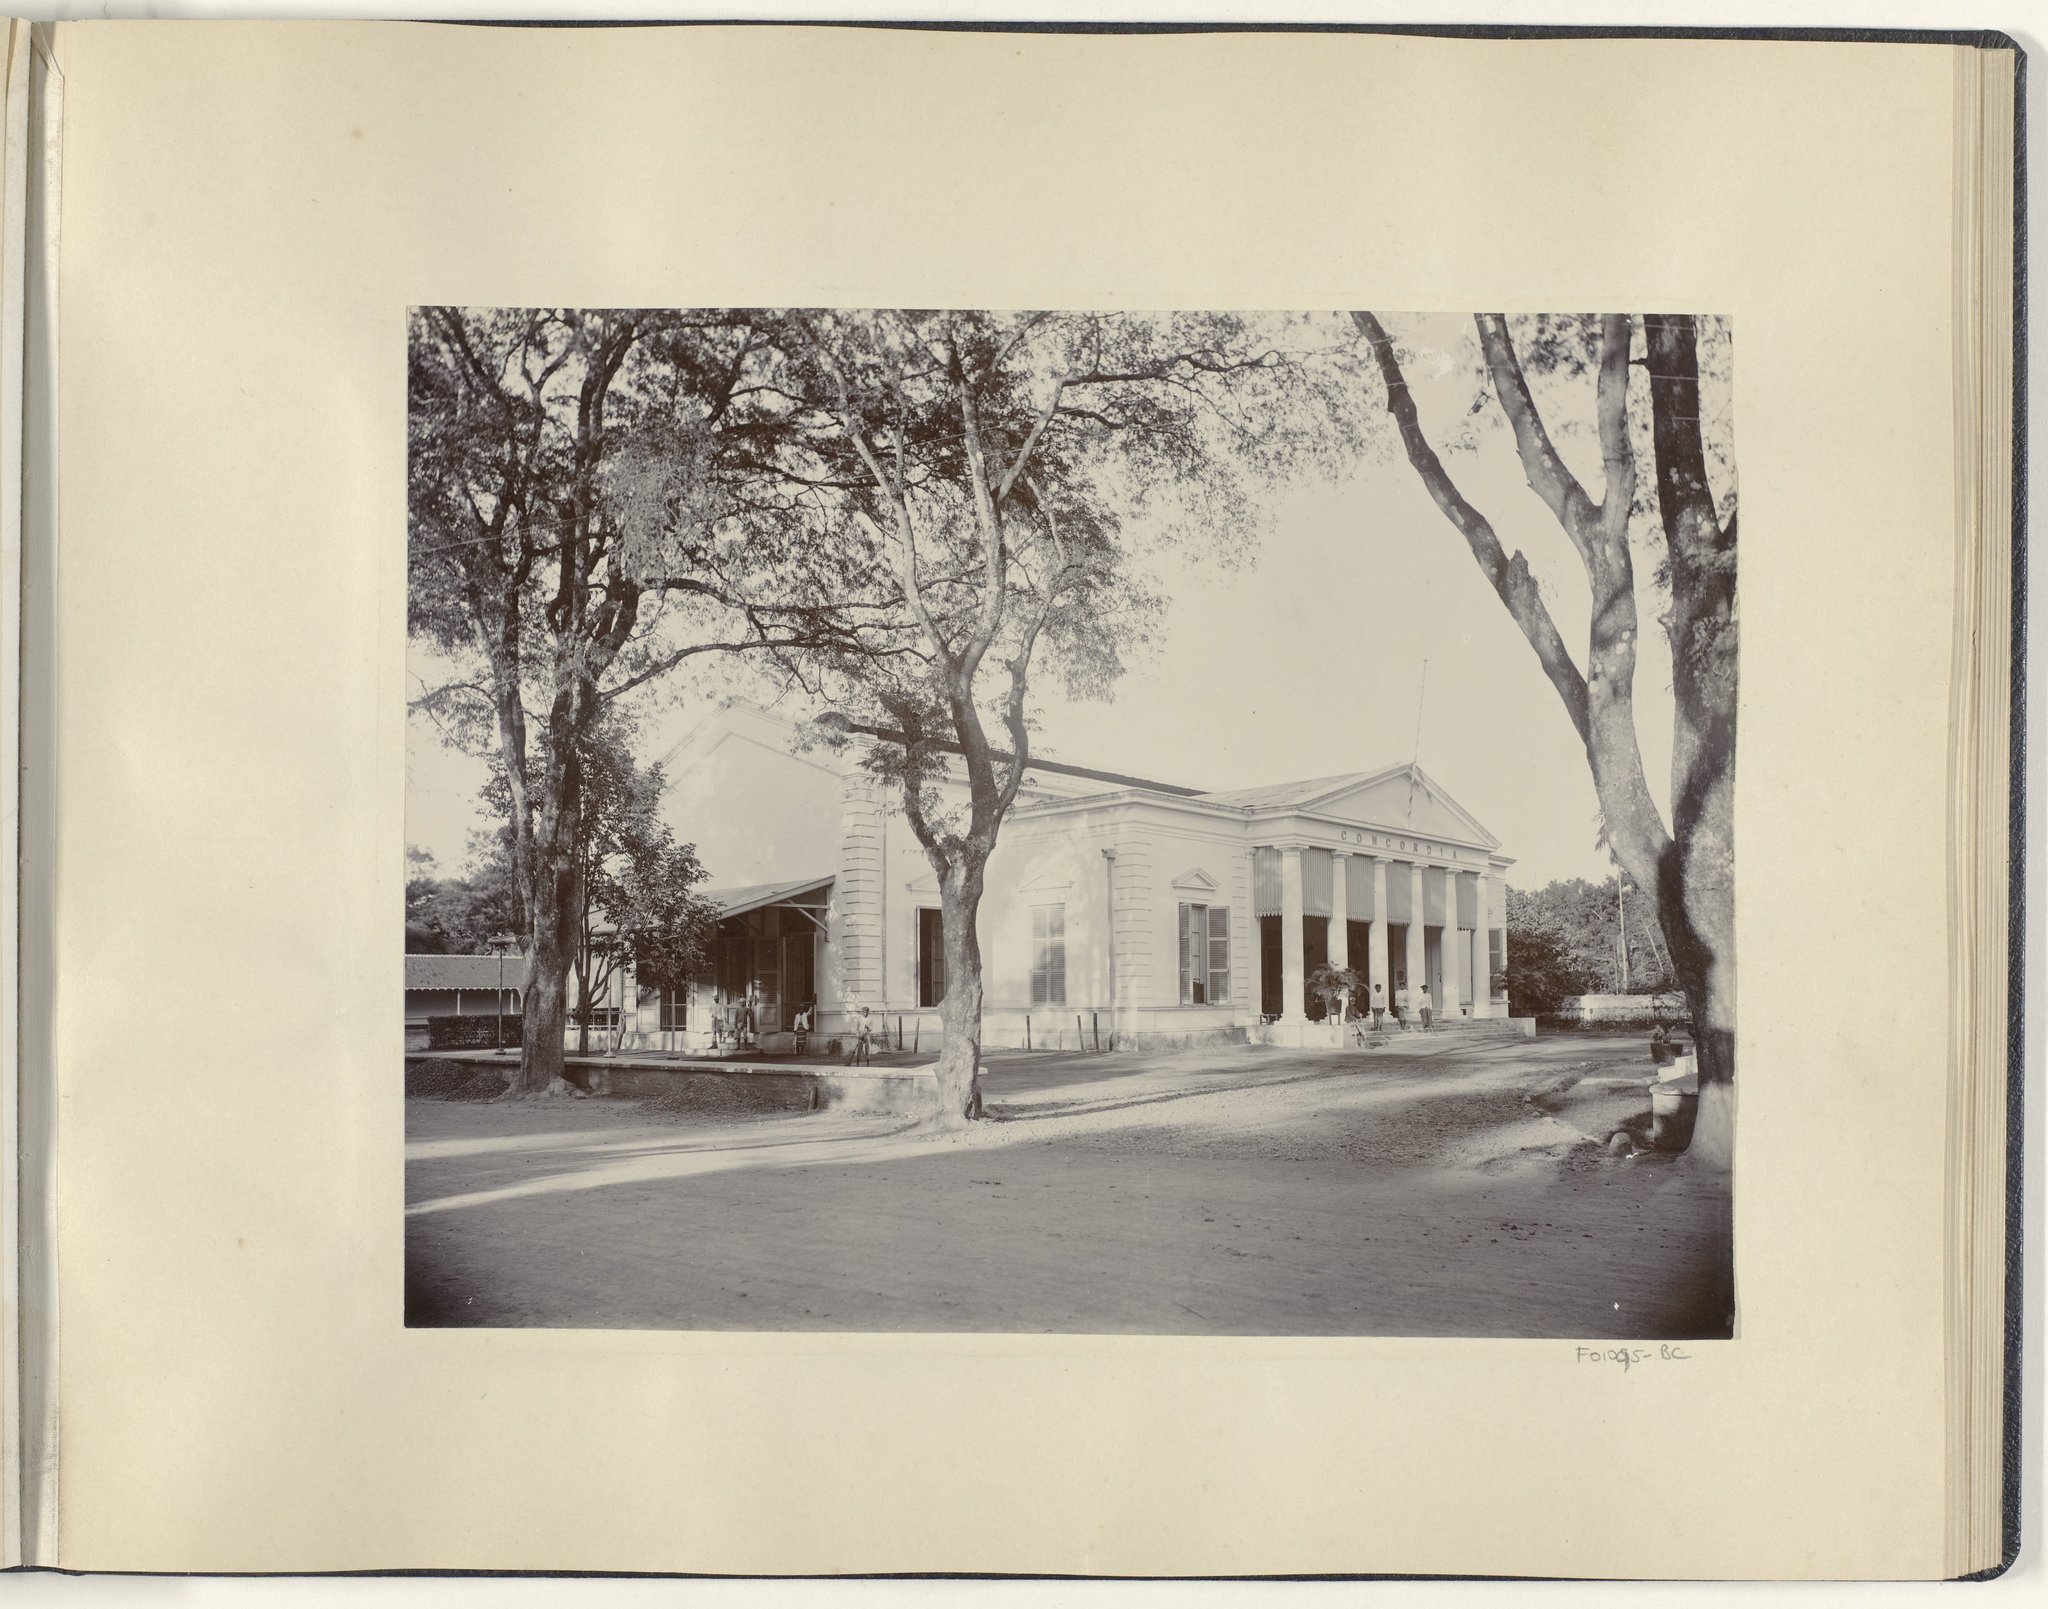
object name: photograph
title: Javaanse bedienden bij Sociëteit Concordia in Weltevreden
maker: Anonymous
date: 1895-1905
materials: paper, photographic support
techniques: gelatin silver print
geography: weltevreden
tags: club, meeting place, house personnel, servants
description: Onderdeel van Reisalbum met foto's van bezienswaardigheden in Italië, Zwitserland en Nederlands-Indië.